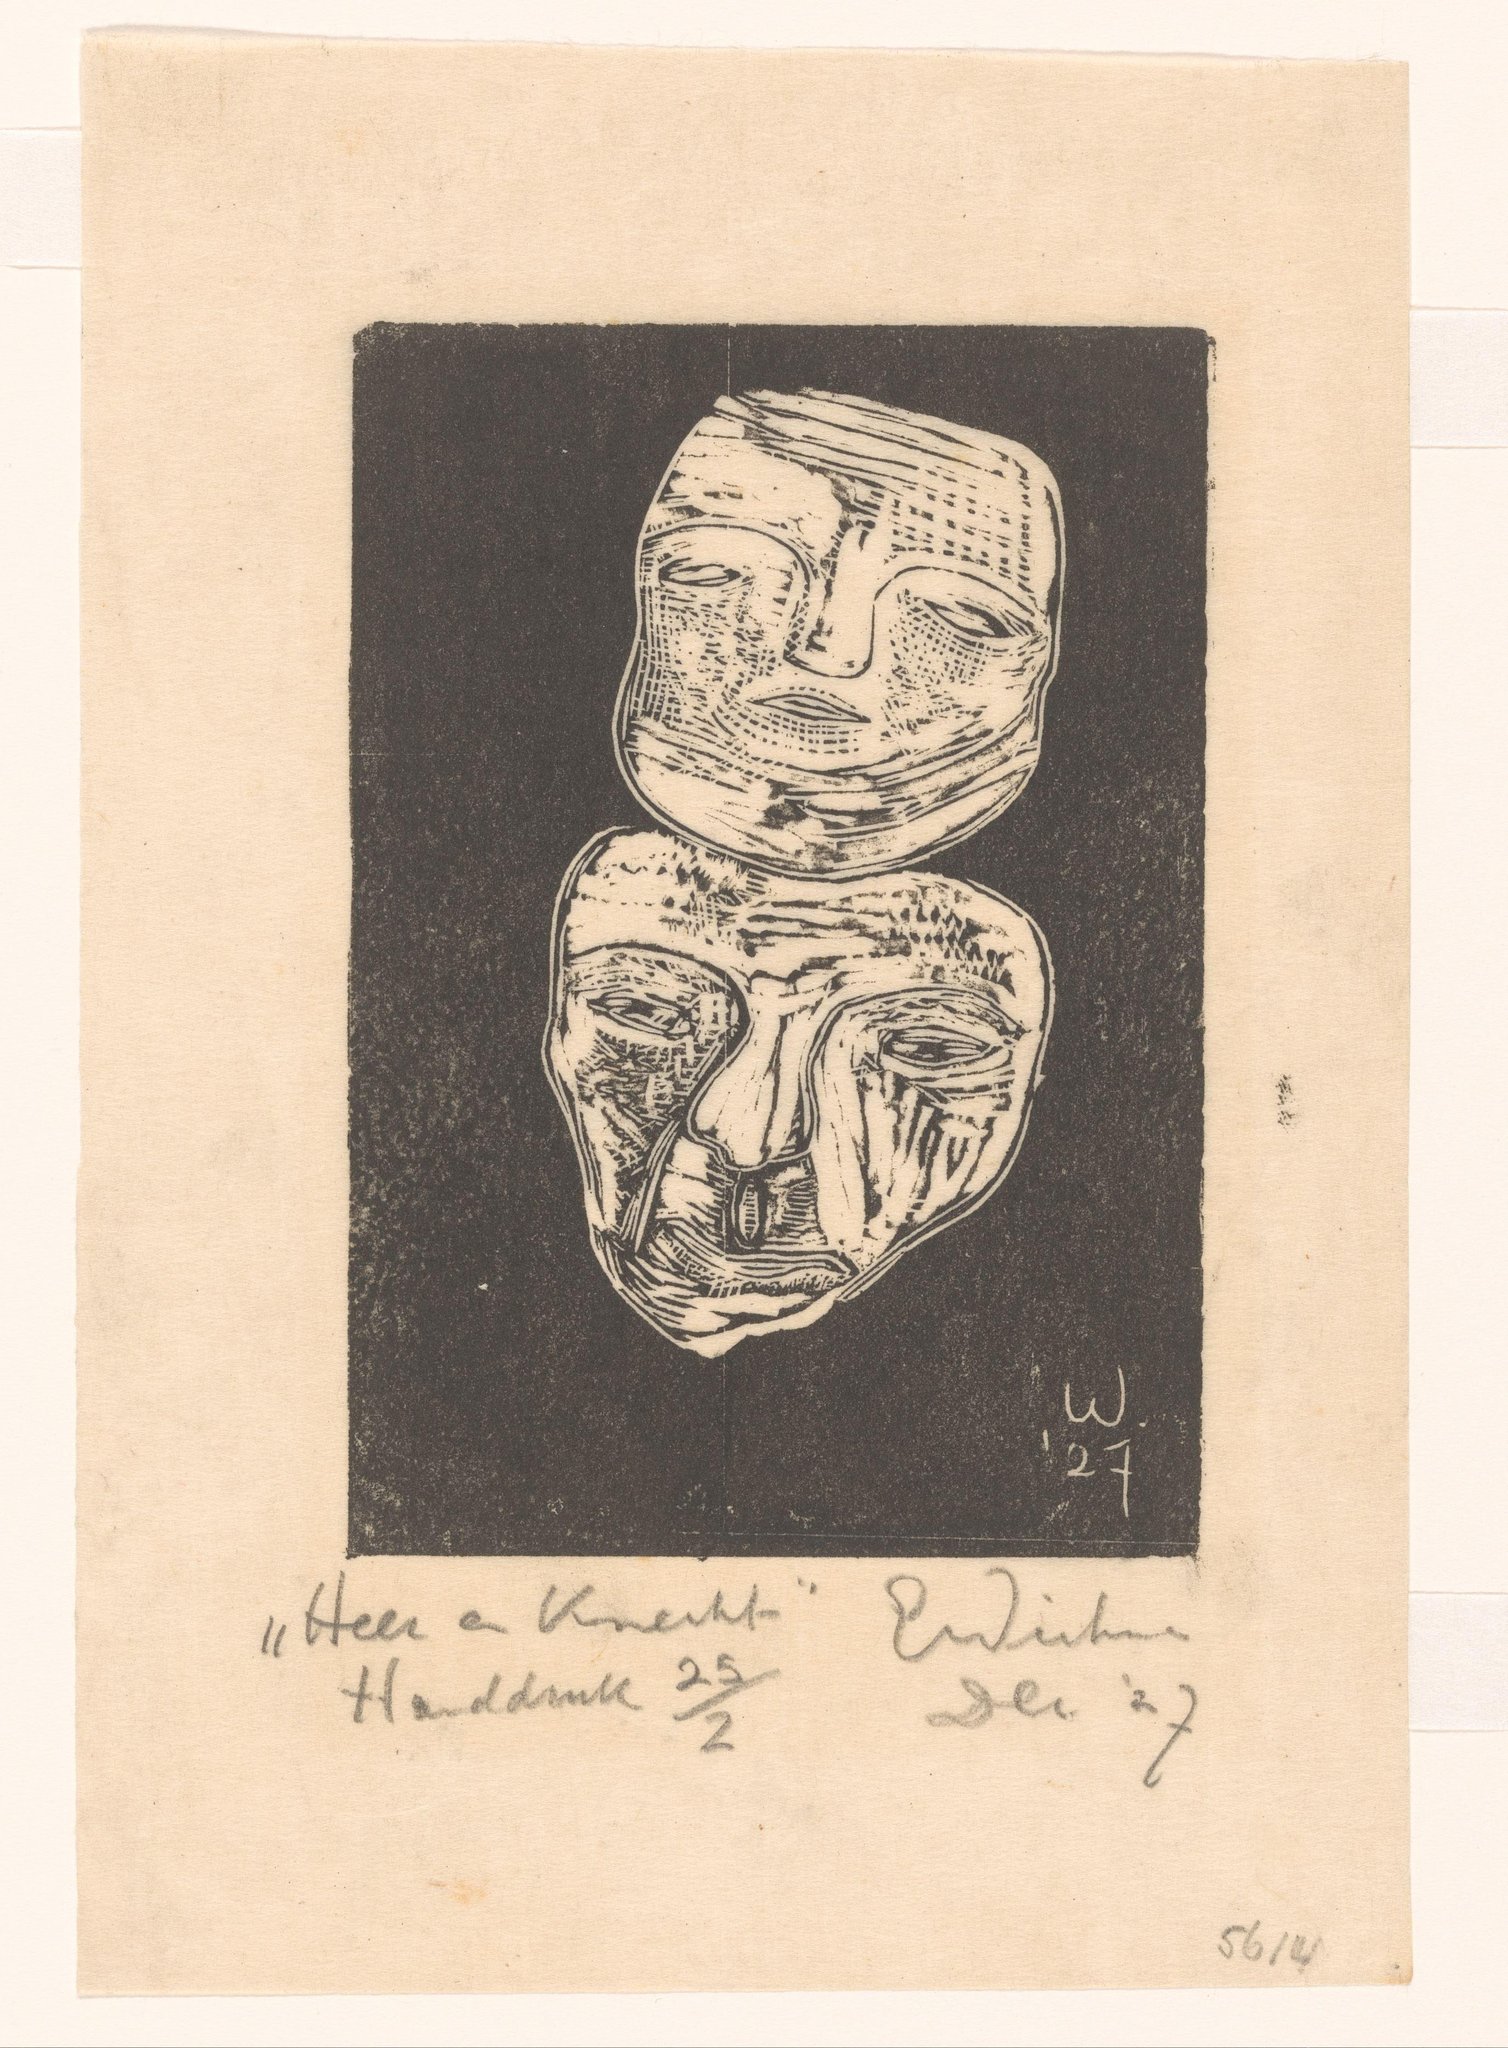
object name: print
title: Heer en knecht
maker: erich wichmann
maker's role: print maker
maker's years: 1890-1929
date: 1912-1927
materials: paper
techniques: woodcut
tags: mask, relation between master and servant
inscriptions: number: ‘5614’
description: Twee maskerachtige gezichten boven elkaar.